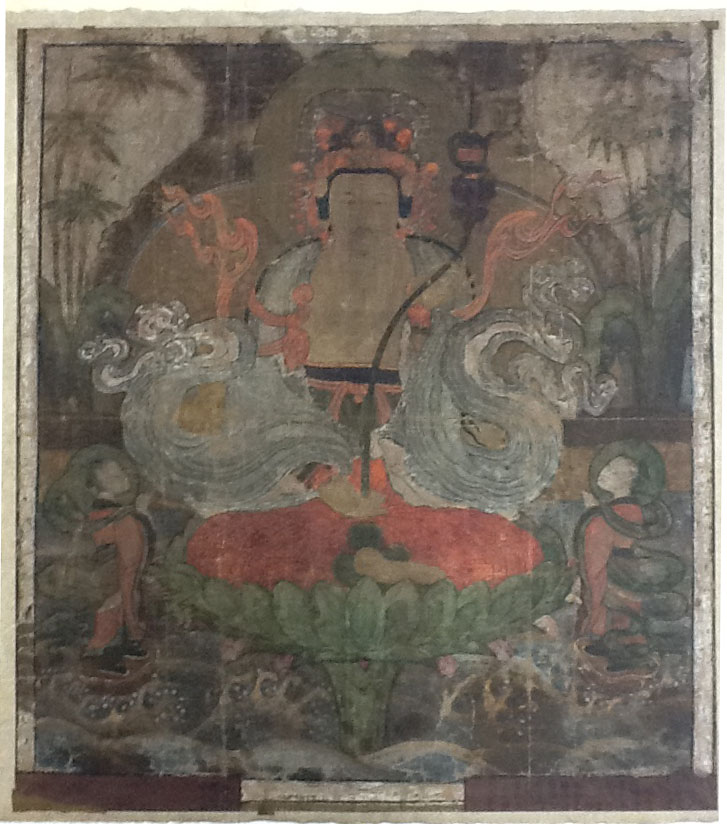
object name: painting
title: Guanyin Seated on a Lotus Throne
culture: korean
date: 1401-1500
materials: ink, silk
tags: lotuses,buddhism,bodhisattvas